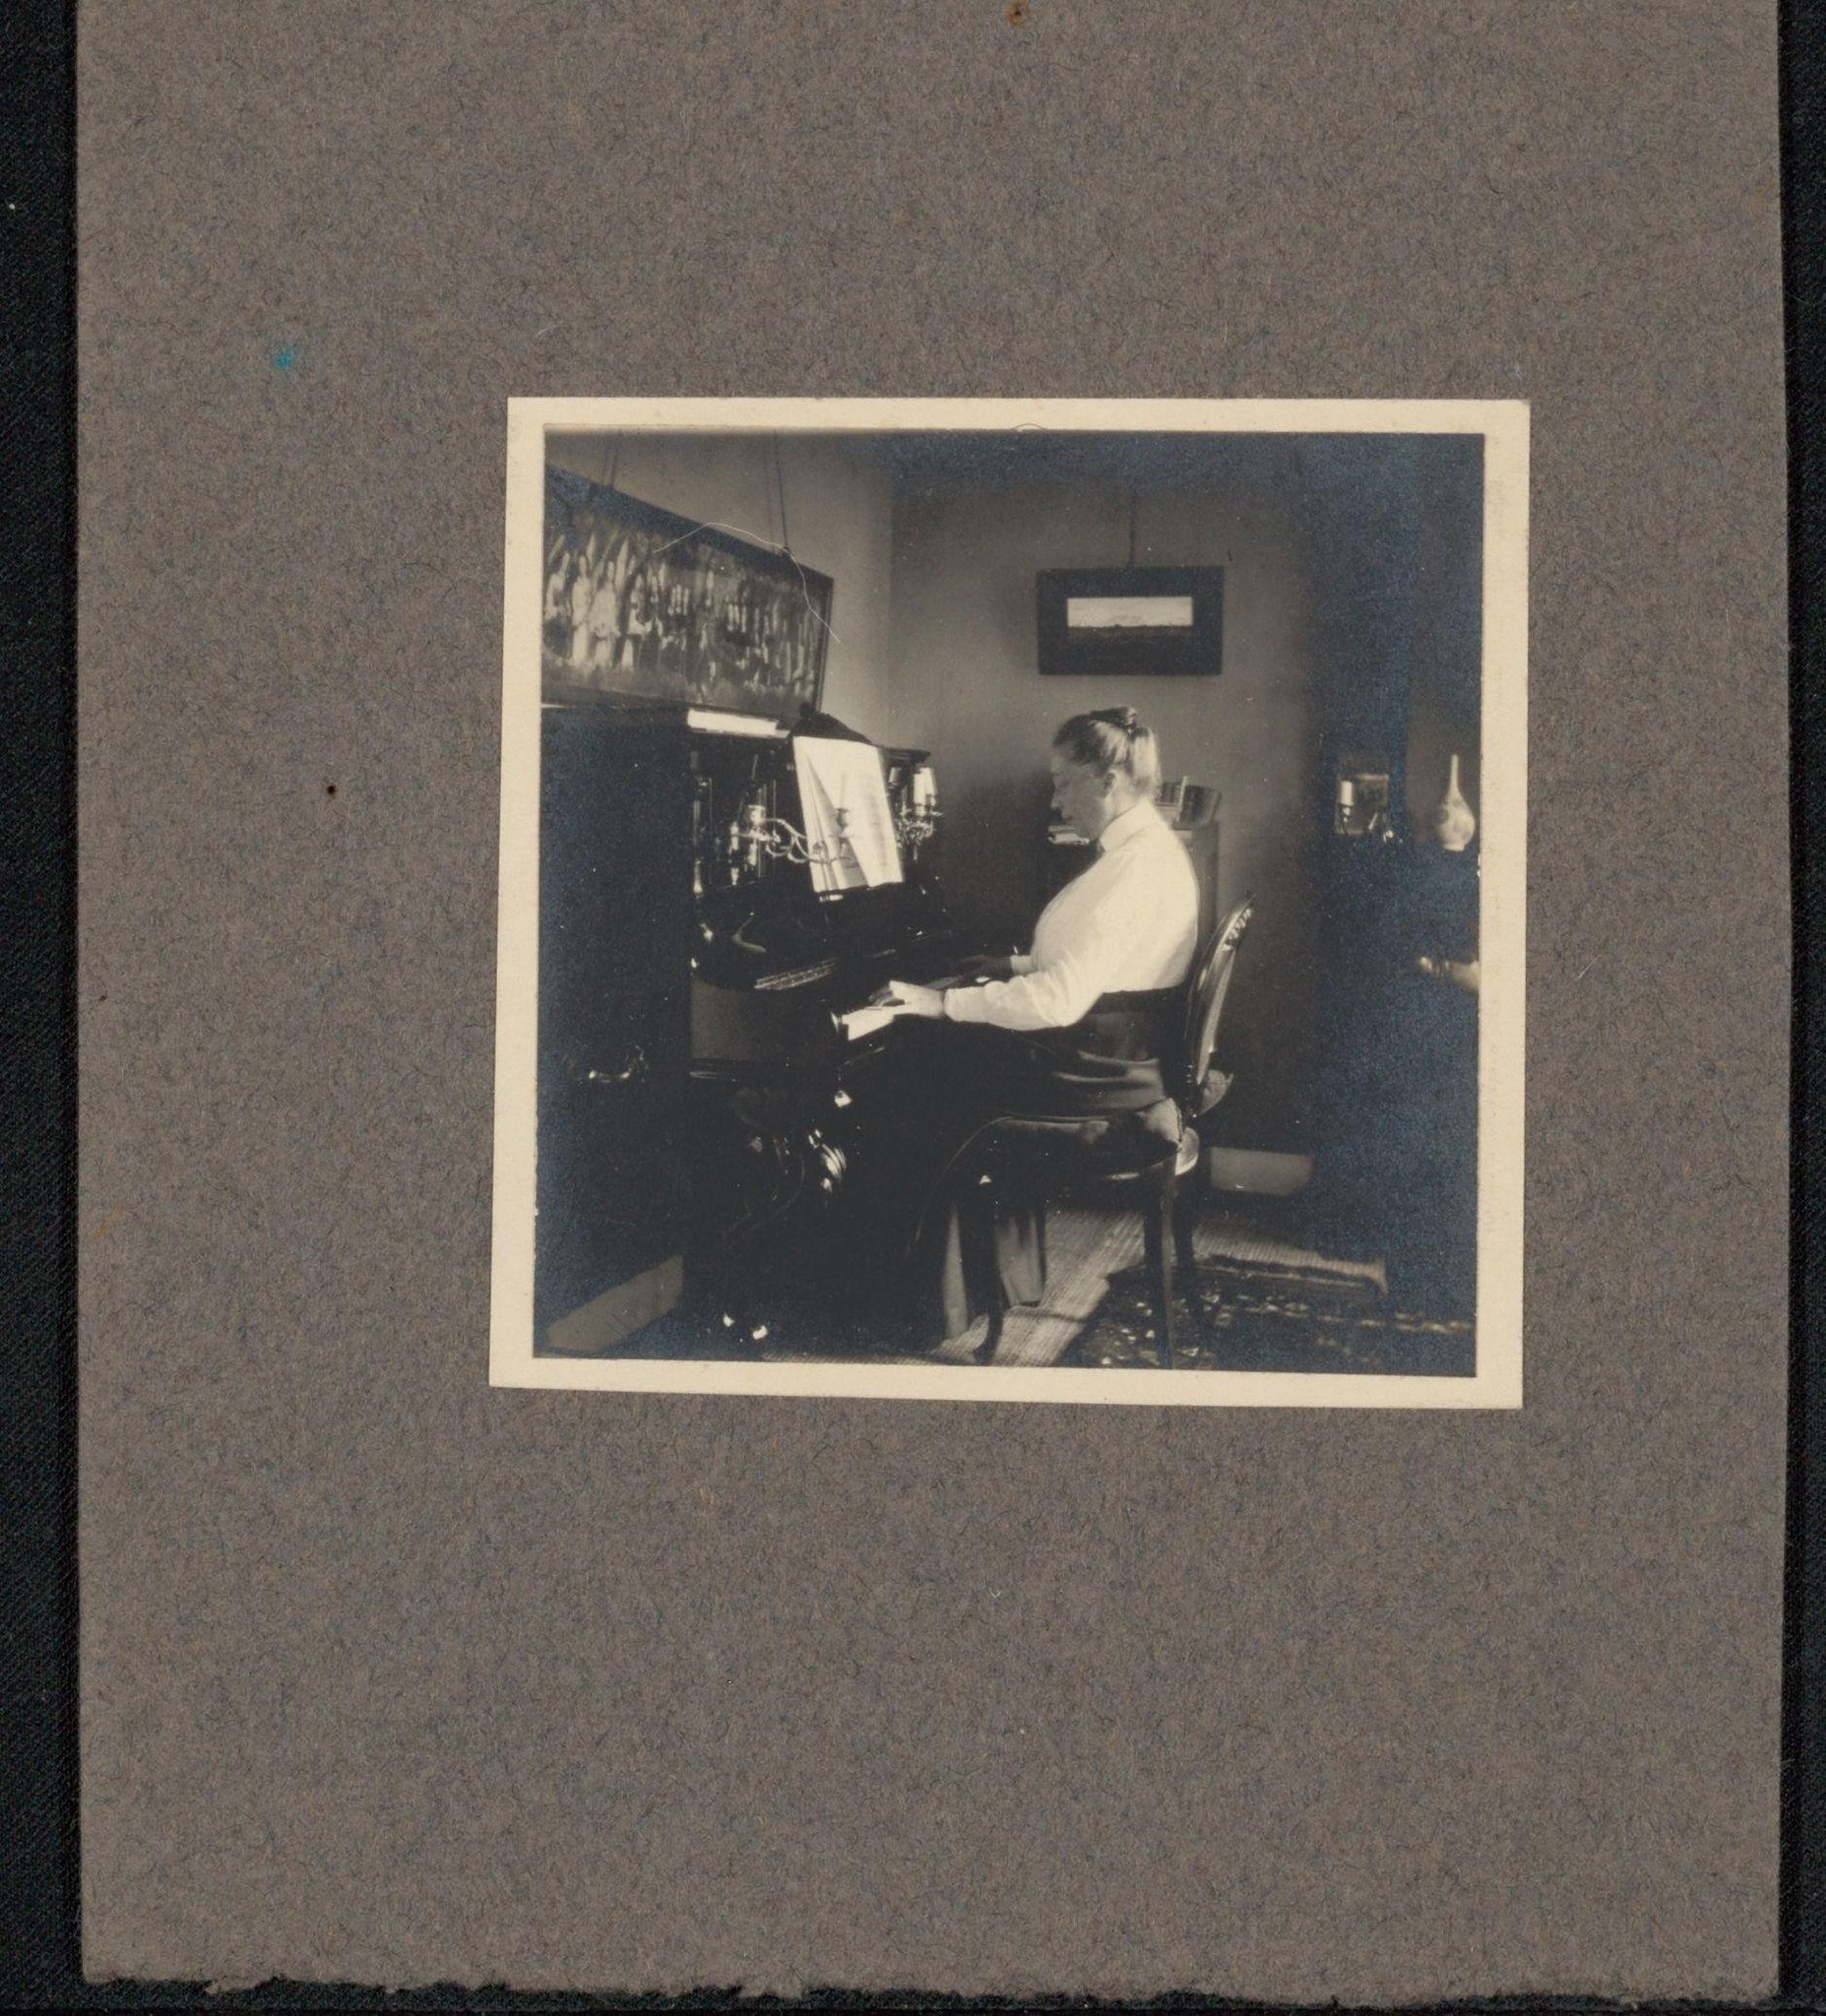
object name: photograph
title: Foto uit archief Jan Veth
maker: Anonymous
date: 1900-1916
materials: cardboard, photographic support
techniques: gelatin silver print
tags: the hague, louise catharina gorter-cnoop koopmans, dordrecht, amsterdam, painter, print maker, draughtsman, designer, jan veth, interior of the house, picture, painting, pianoforte, historical persons (portraits and scenes from the life)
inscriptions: collector's mark: ‘RPK’